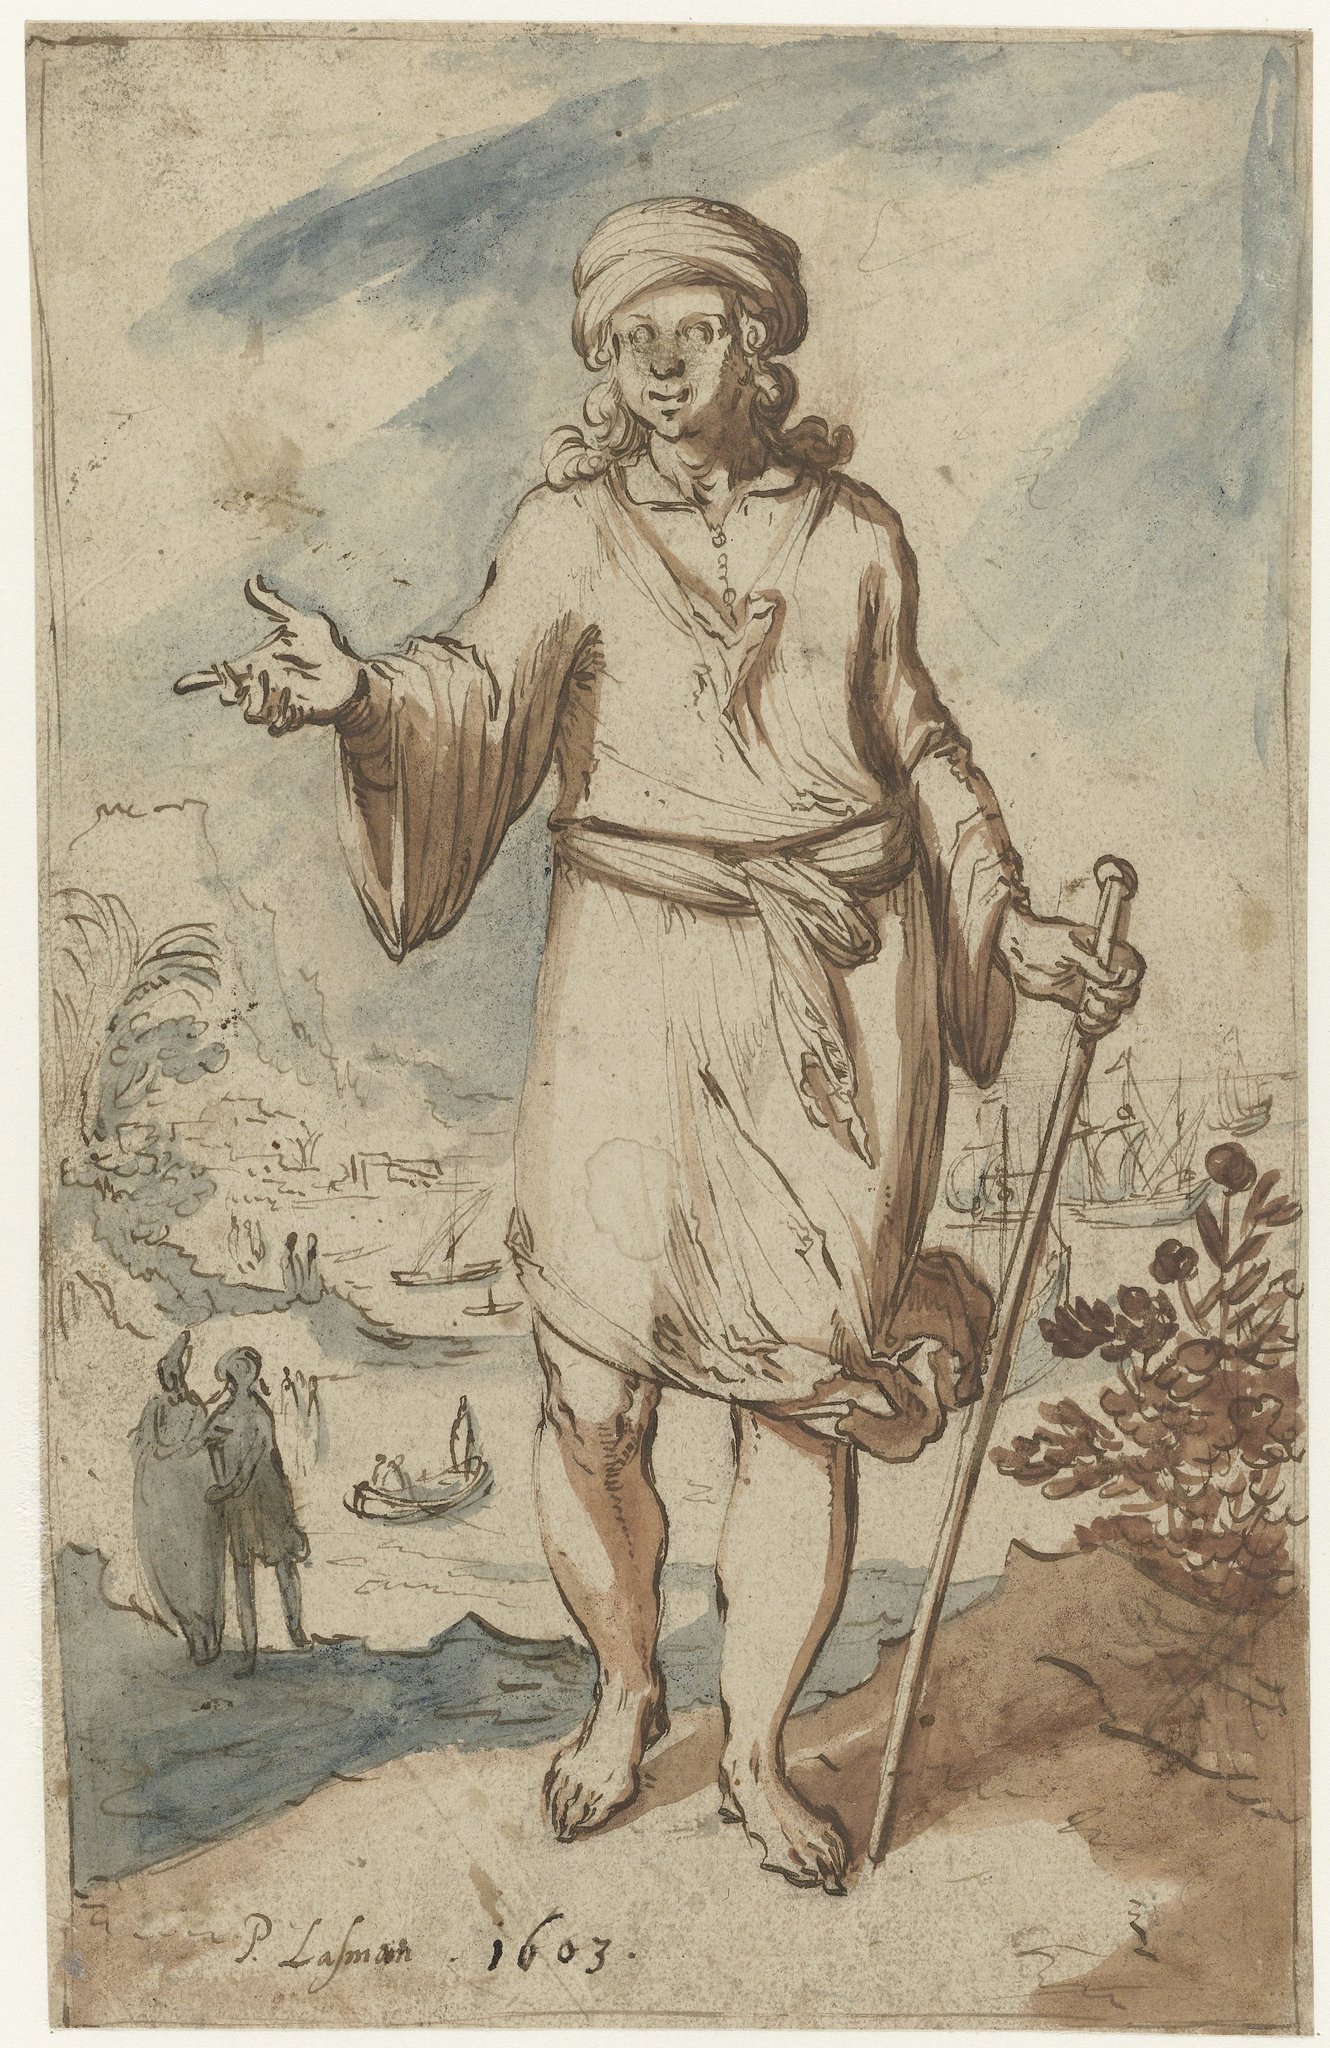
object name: drawing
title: Standing Man in Oriental Dress, Seen From the Front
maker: pieter lastman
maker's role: draughtsman, painter, print maker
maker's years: 1583-1633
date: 1603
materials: chalk, ink, paper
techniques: brush, pen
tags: asiatic races and peoples, standing figure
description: Lastman drew this sympathetic young man wearing a turban and a graceful tunic in two different poses at the beginning of his career. The influence of the Mannerist style of his teacher Gerrit Pietersz can still be discerned: notice the elongated, elegant fingers and pointed toes. The inscription ‘P. Lastman’ on both sheets was added by their later owner Gerard ter Borch the Elder, with whom Lastman became acquainted in Rome.